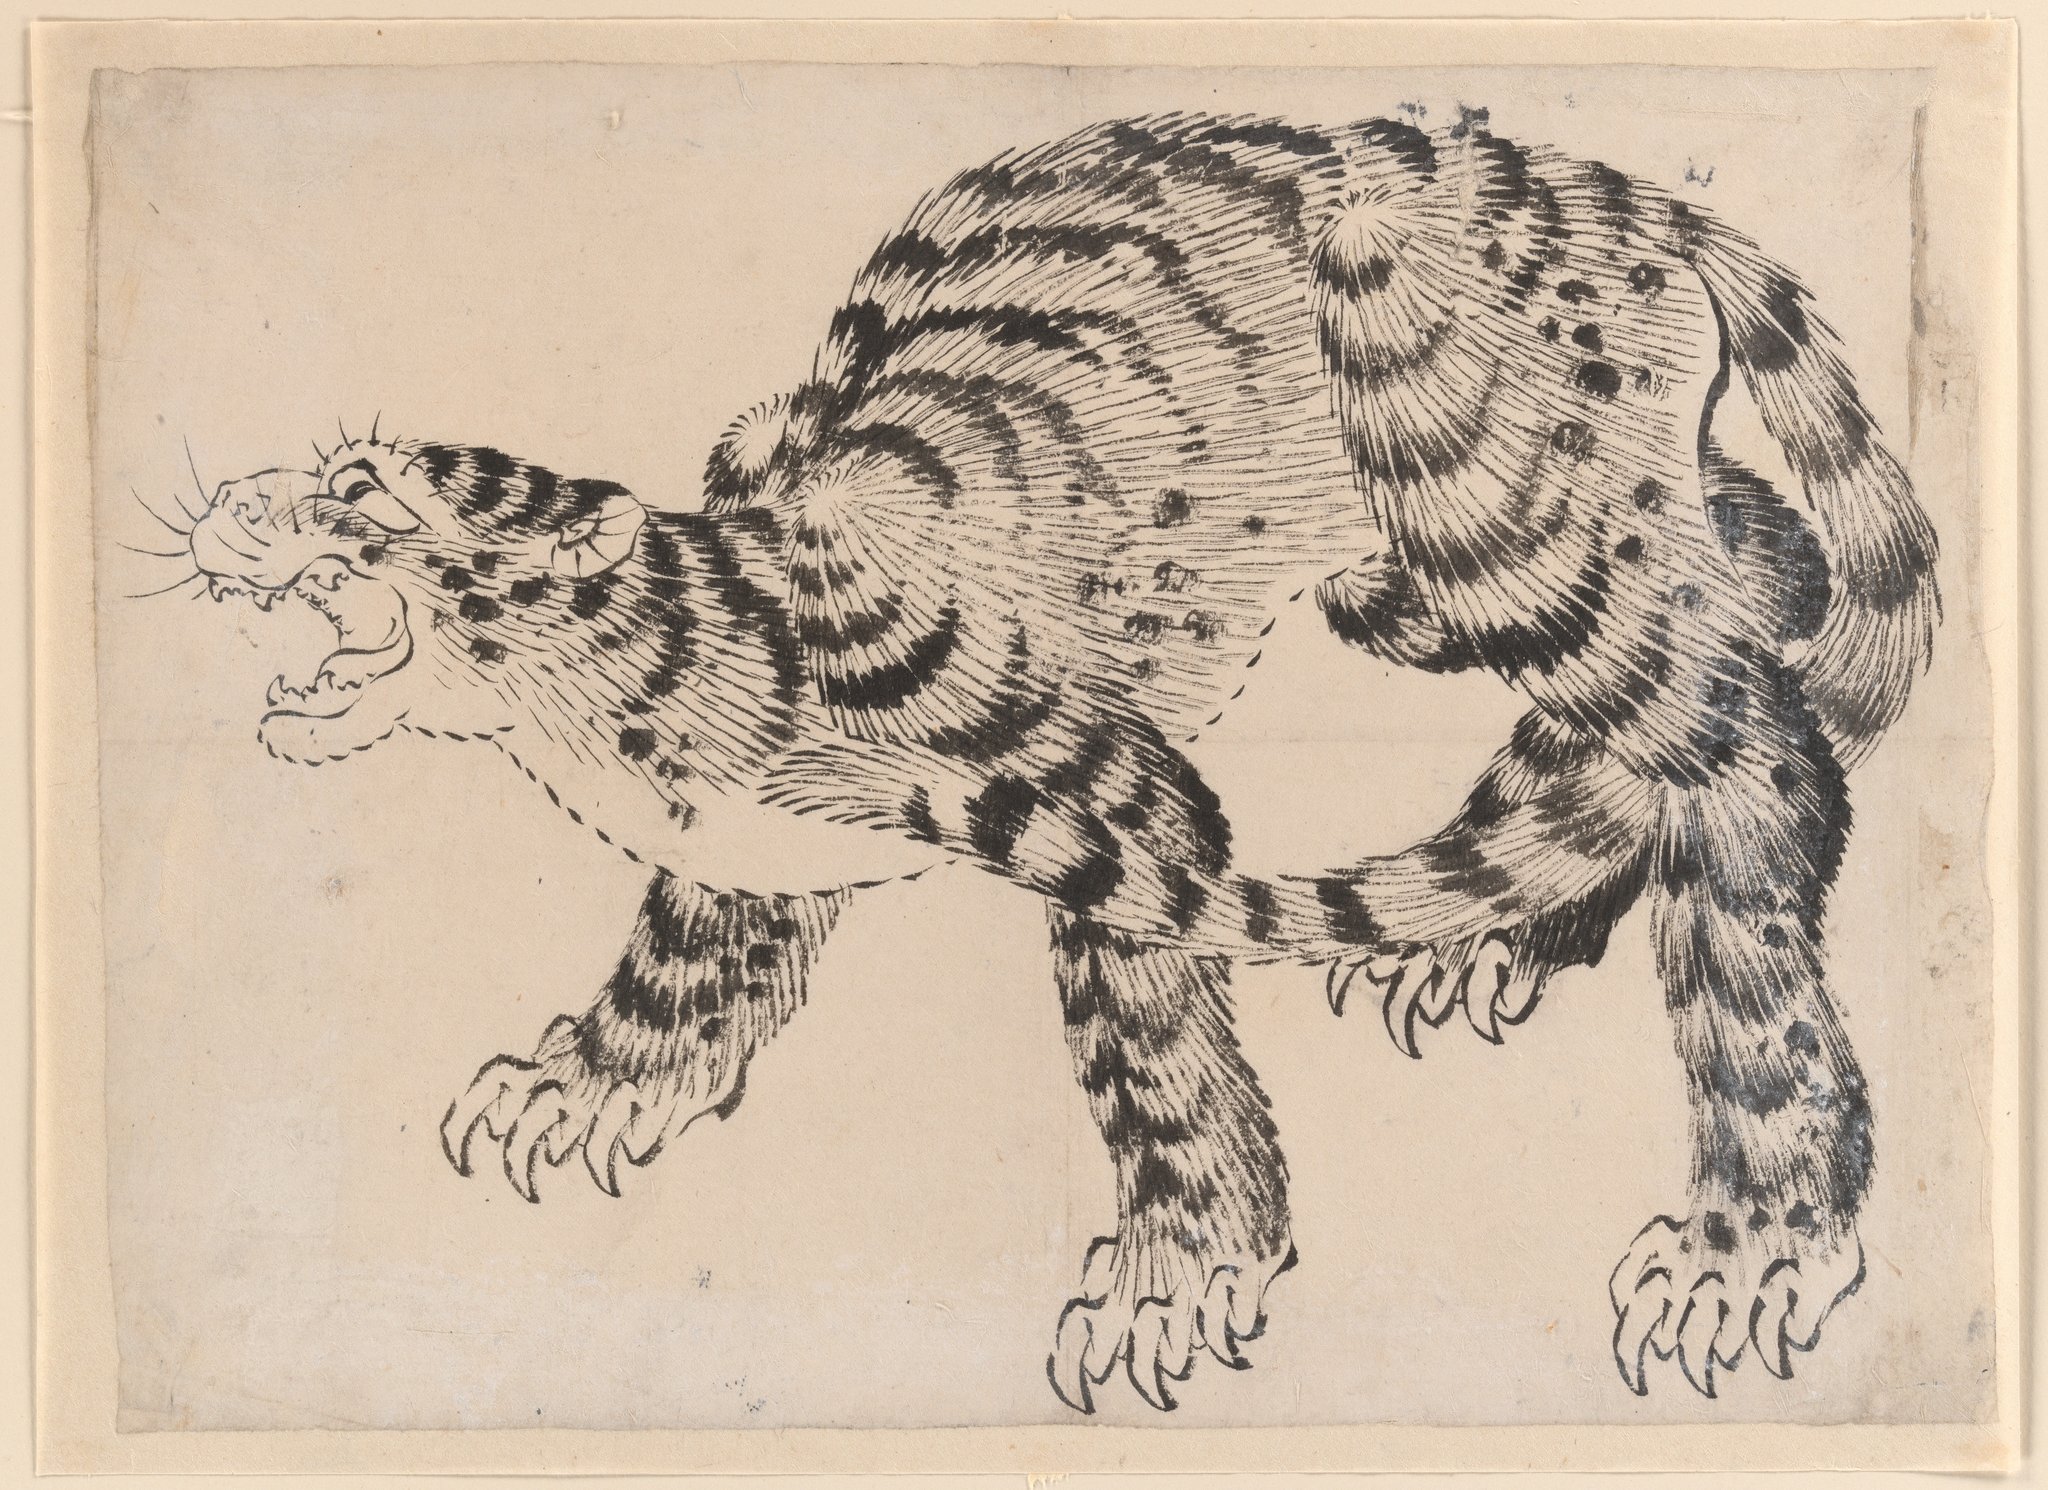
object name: painting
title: Tiger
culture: japanese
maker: hokusai school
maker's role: artist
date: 1801-1900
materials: ink, paper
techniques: painting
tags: tigers